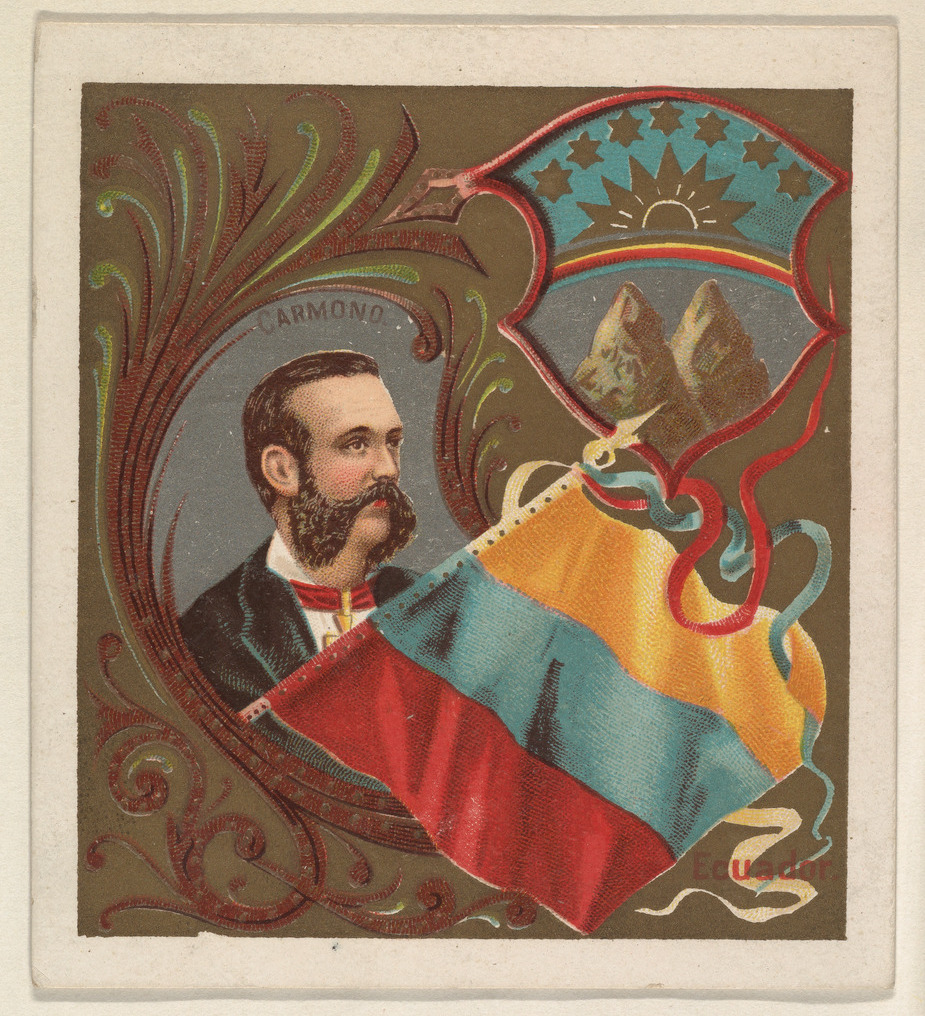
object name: print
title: Ecuador, from the International Cards series (N238), issued by Kinney Bros.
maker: kinney brothers tobacco company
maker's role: publisher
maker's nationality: american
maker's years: 1869-2011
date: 1888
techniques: color lithograph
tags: men,flags